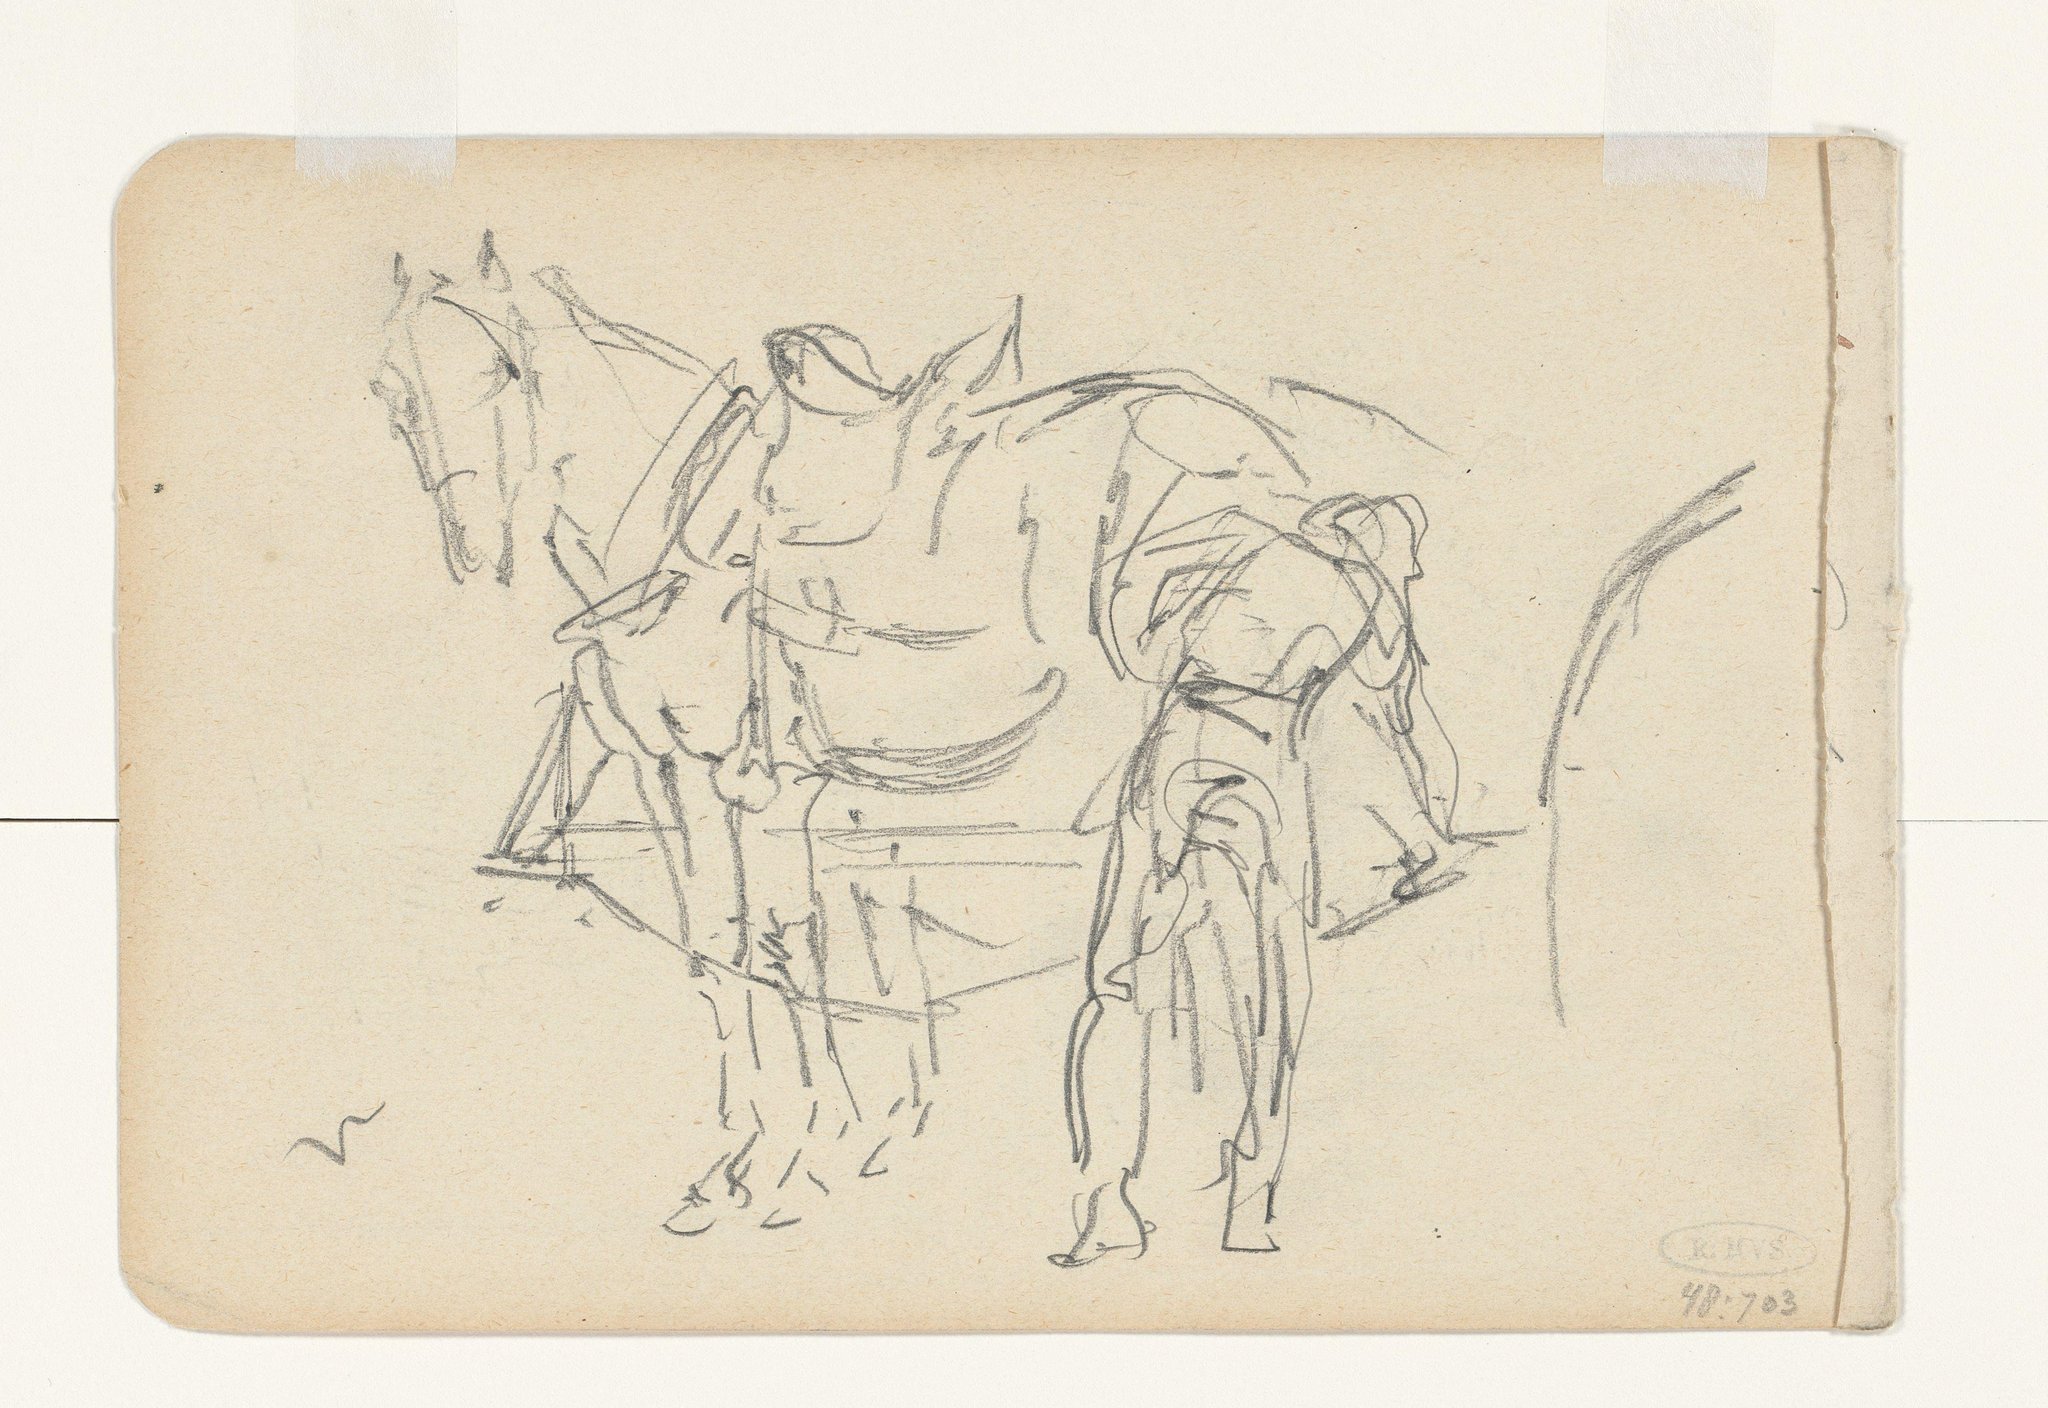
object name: drawing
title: Man bij aangelijnd paard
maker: jan hoynck van papendrecht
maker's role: draughtsman, painter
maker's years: 1858-1933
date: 1868-1933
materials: paper, pencil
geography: amsterdam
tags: horse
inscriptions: collector's mark: Lugt 2228